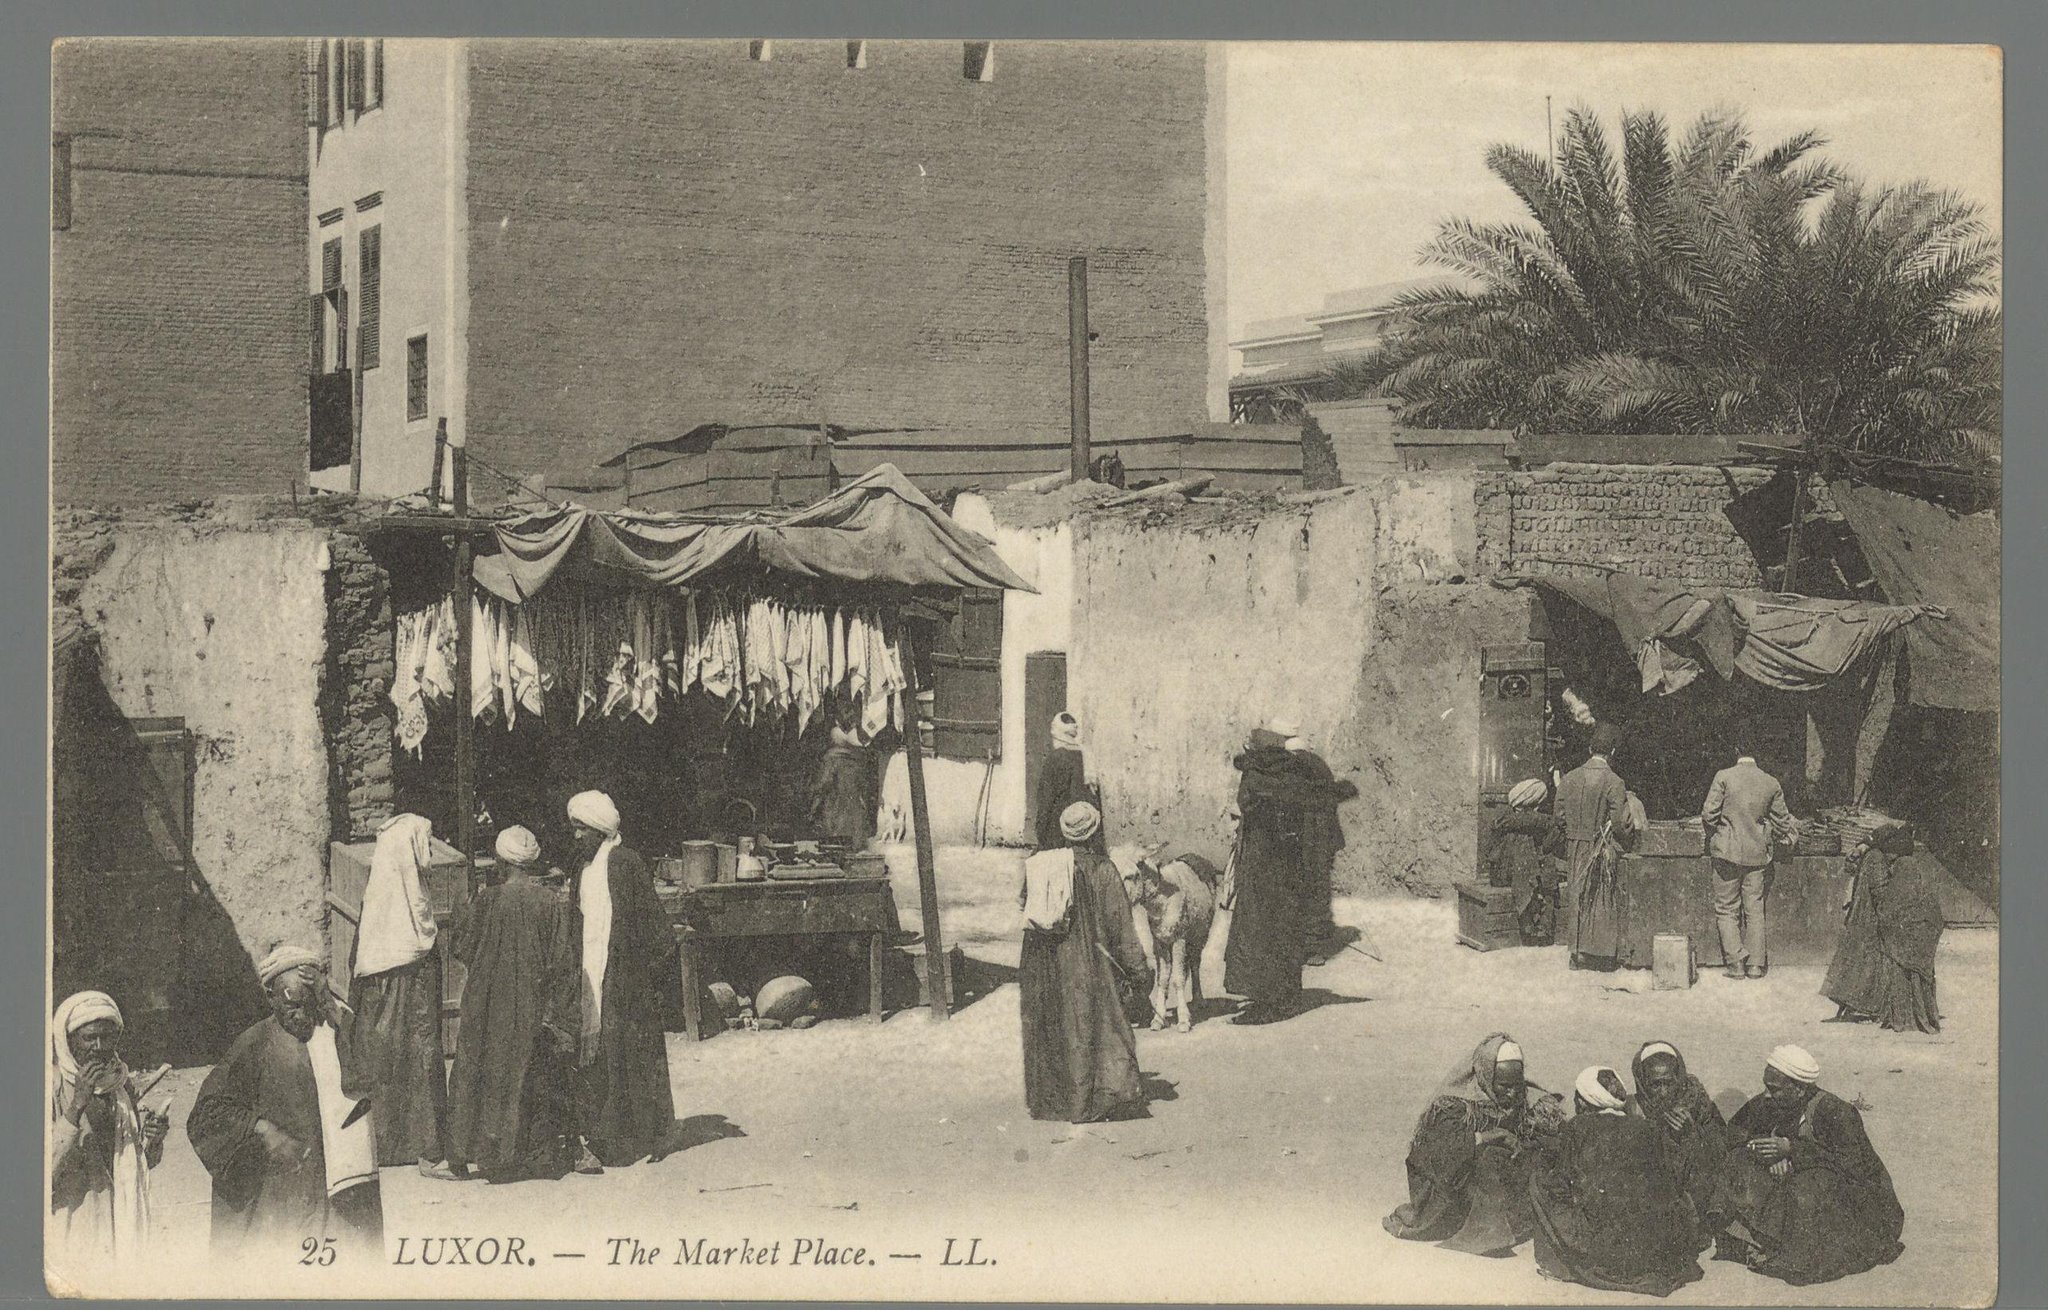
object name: photomechanical print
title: Luxor - The market place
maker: Anonymous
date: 1907-1930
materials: cardboard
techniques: photograph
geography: paris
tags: stall, booth (~ market), market